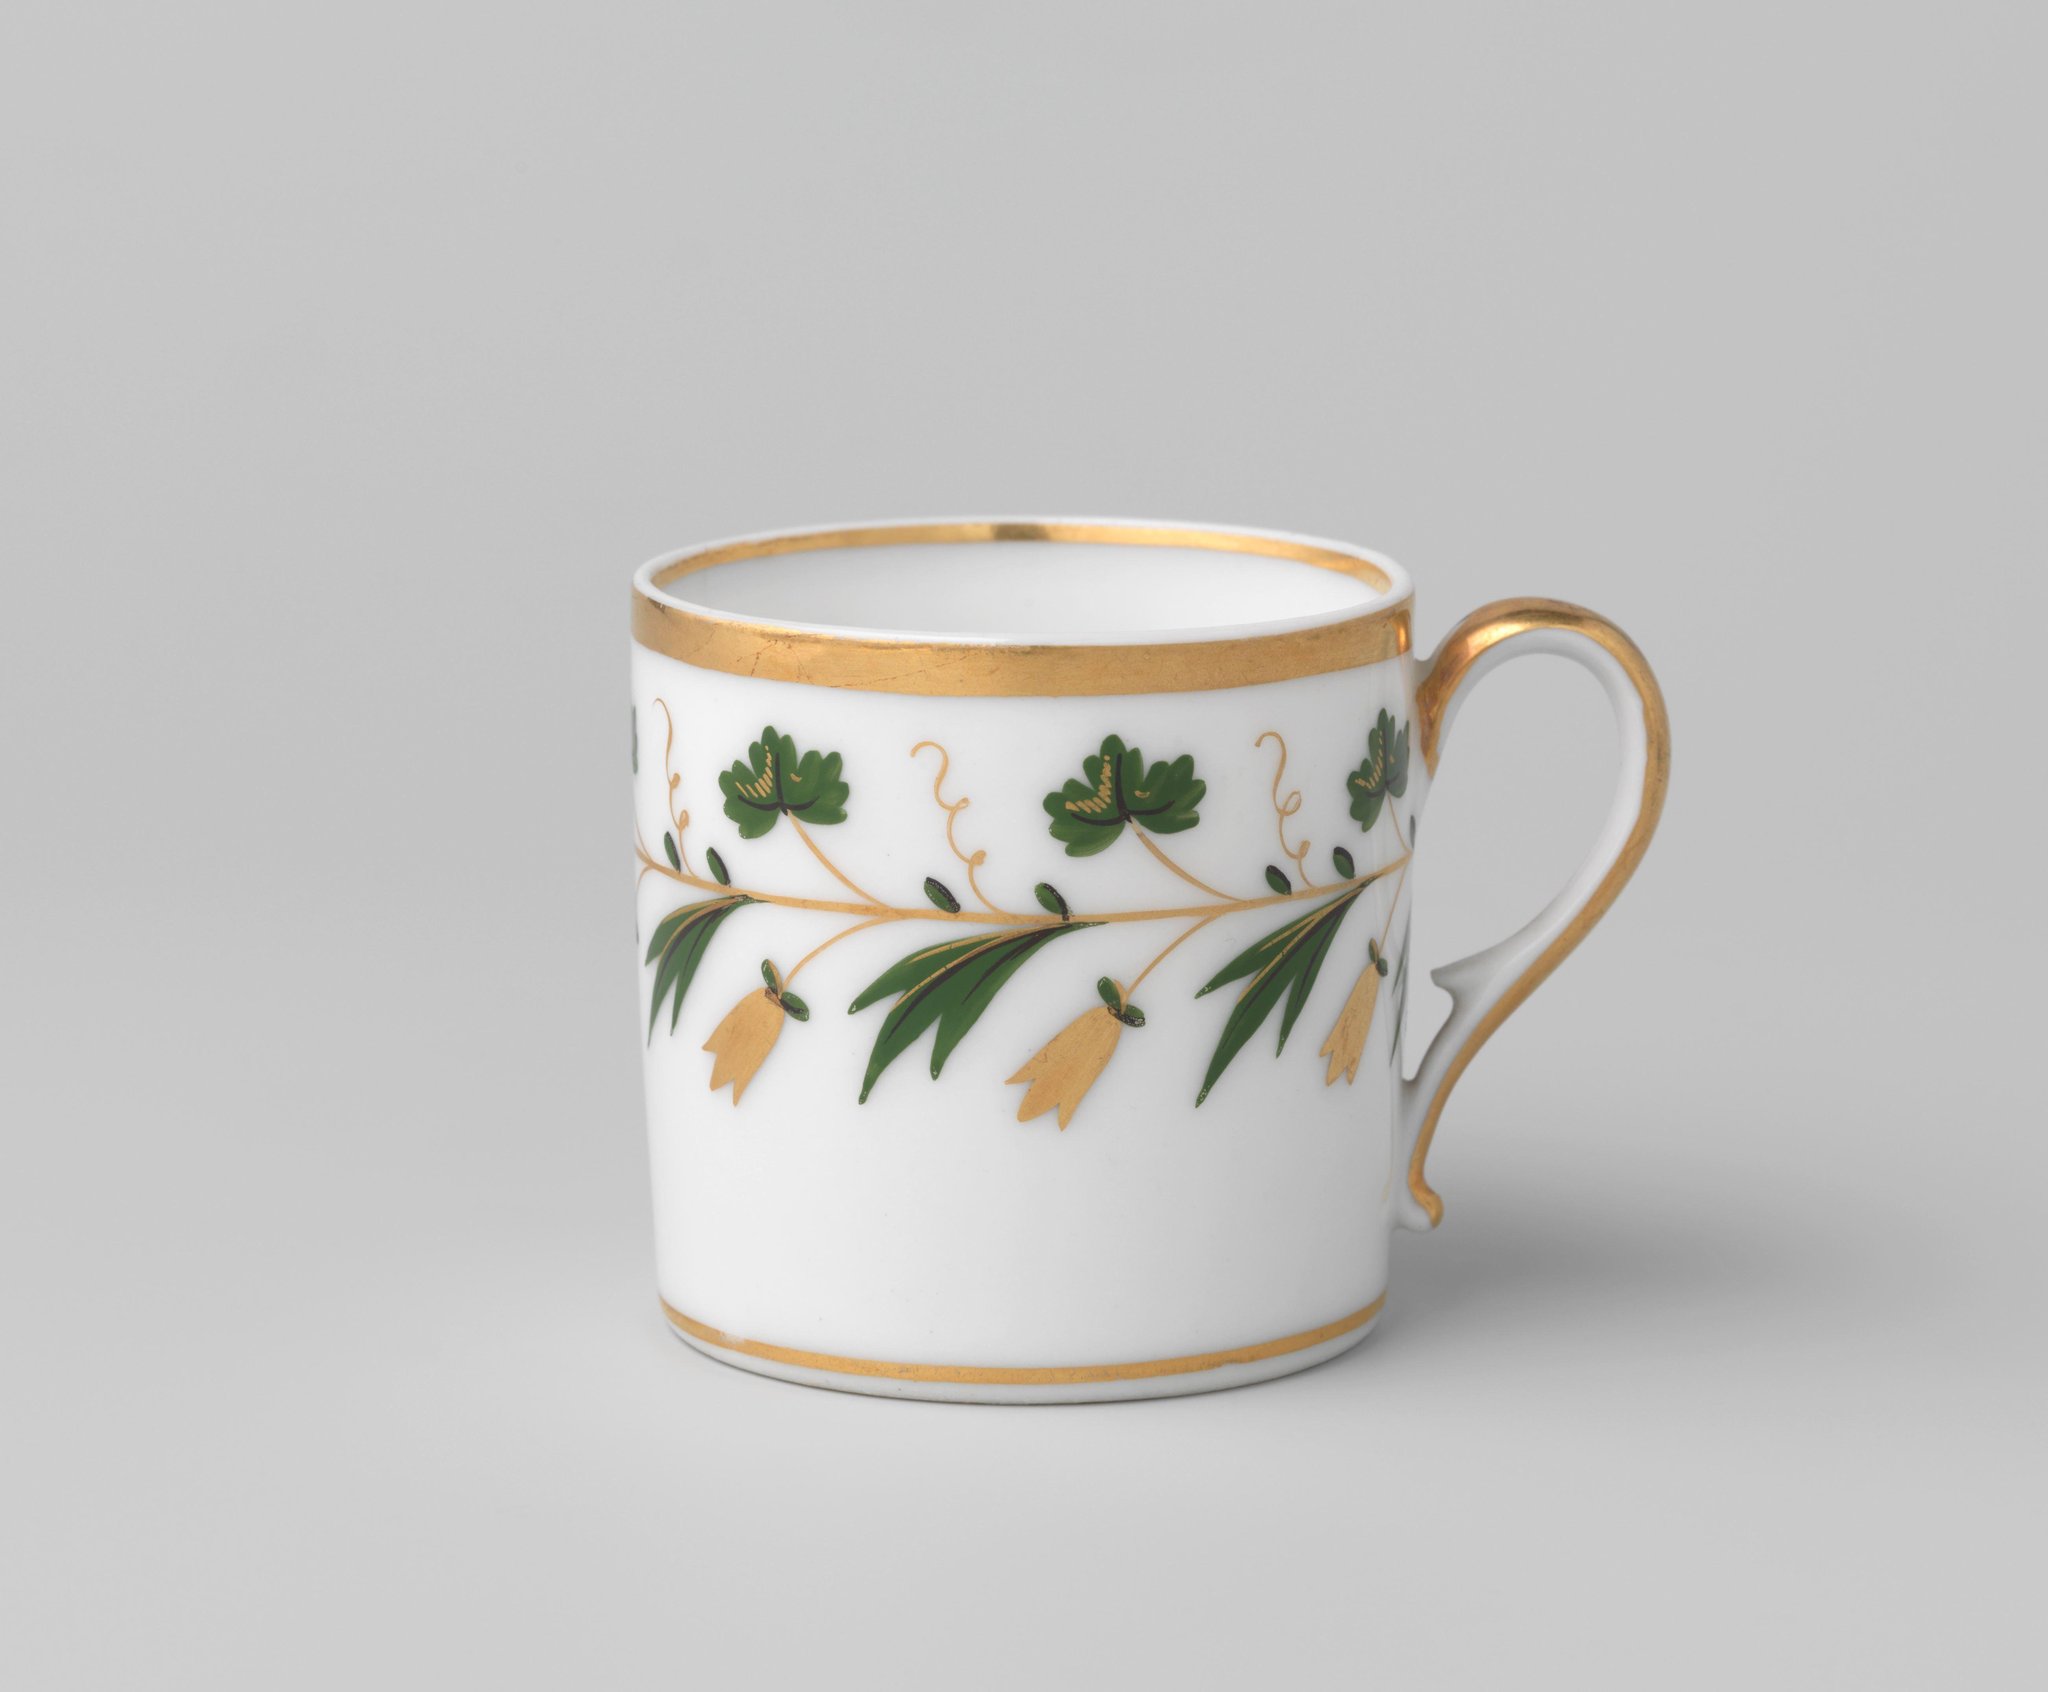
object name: cup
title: Cup with a border of grapevines and flowers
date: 1800-1824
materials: glaze, gold, paint, porcelain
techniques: firing, forming, gilding, turning, vitrification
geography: paris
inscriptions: mark: ‘gekruiste pijlen’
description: Kop van porselein met een cilindrische wand en C-vormig oor, beschilderd op het glazuur in groen, zwart en goud. Op de buitenwand een band met aan de ene zijde wijnranken en aan de andere zijde bloemen en bladeren. Gouden rand, voet en oor. Gemerkt op de onderzijde met de gekruiste pijlen.